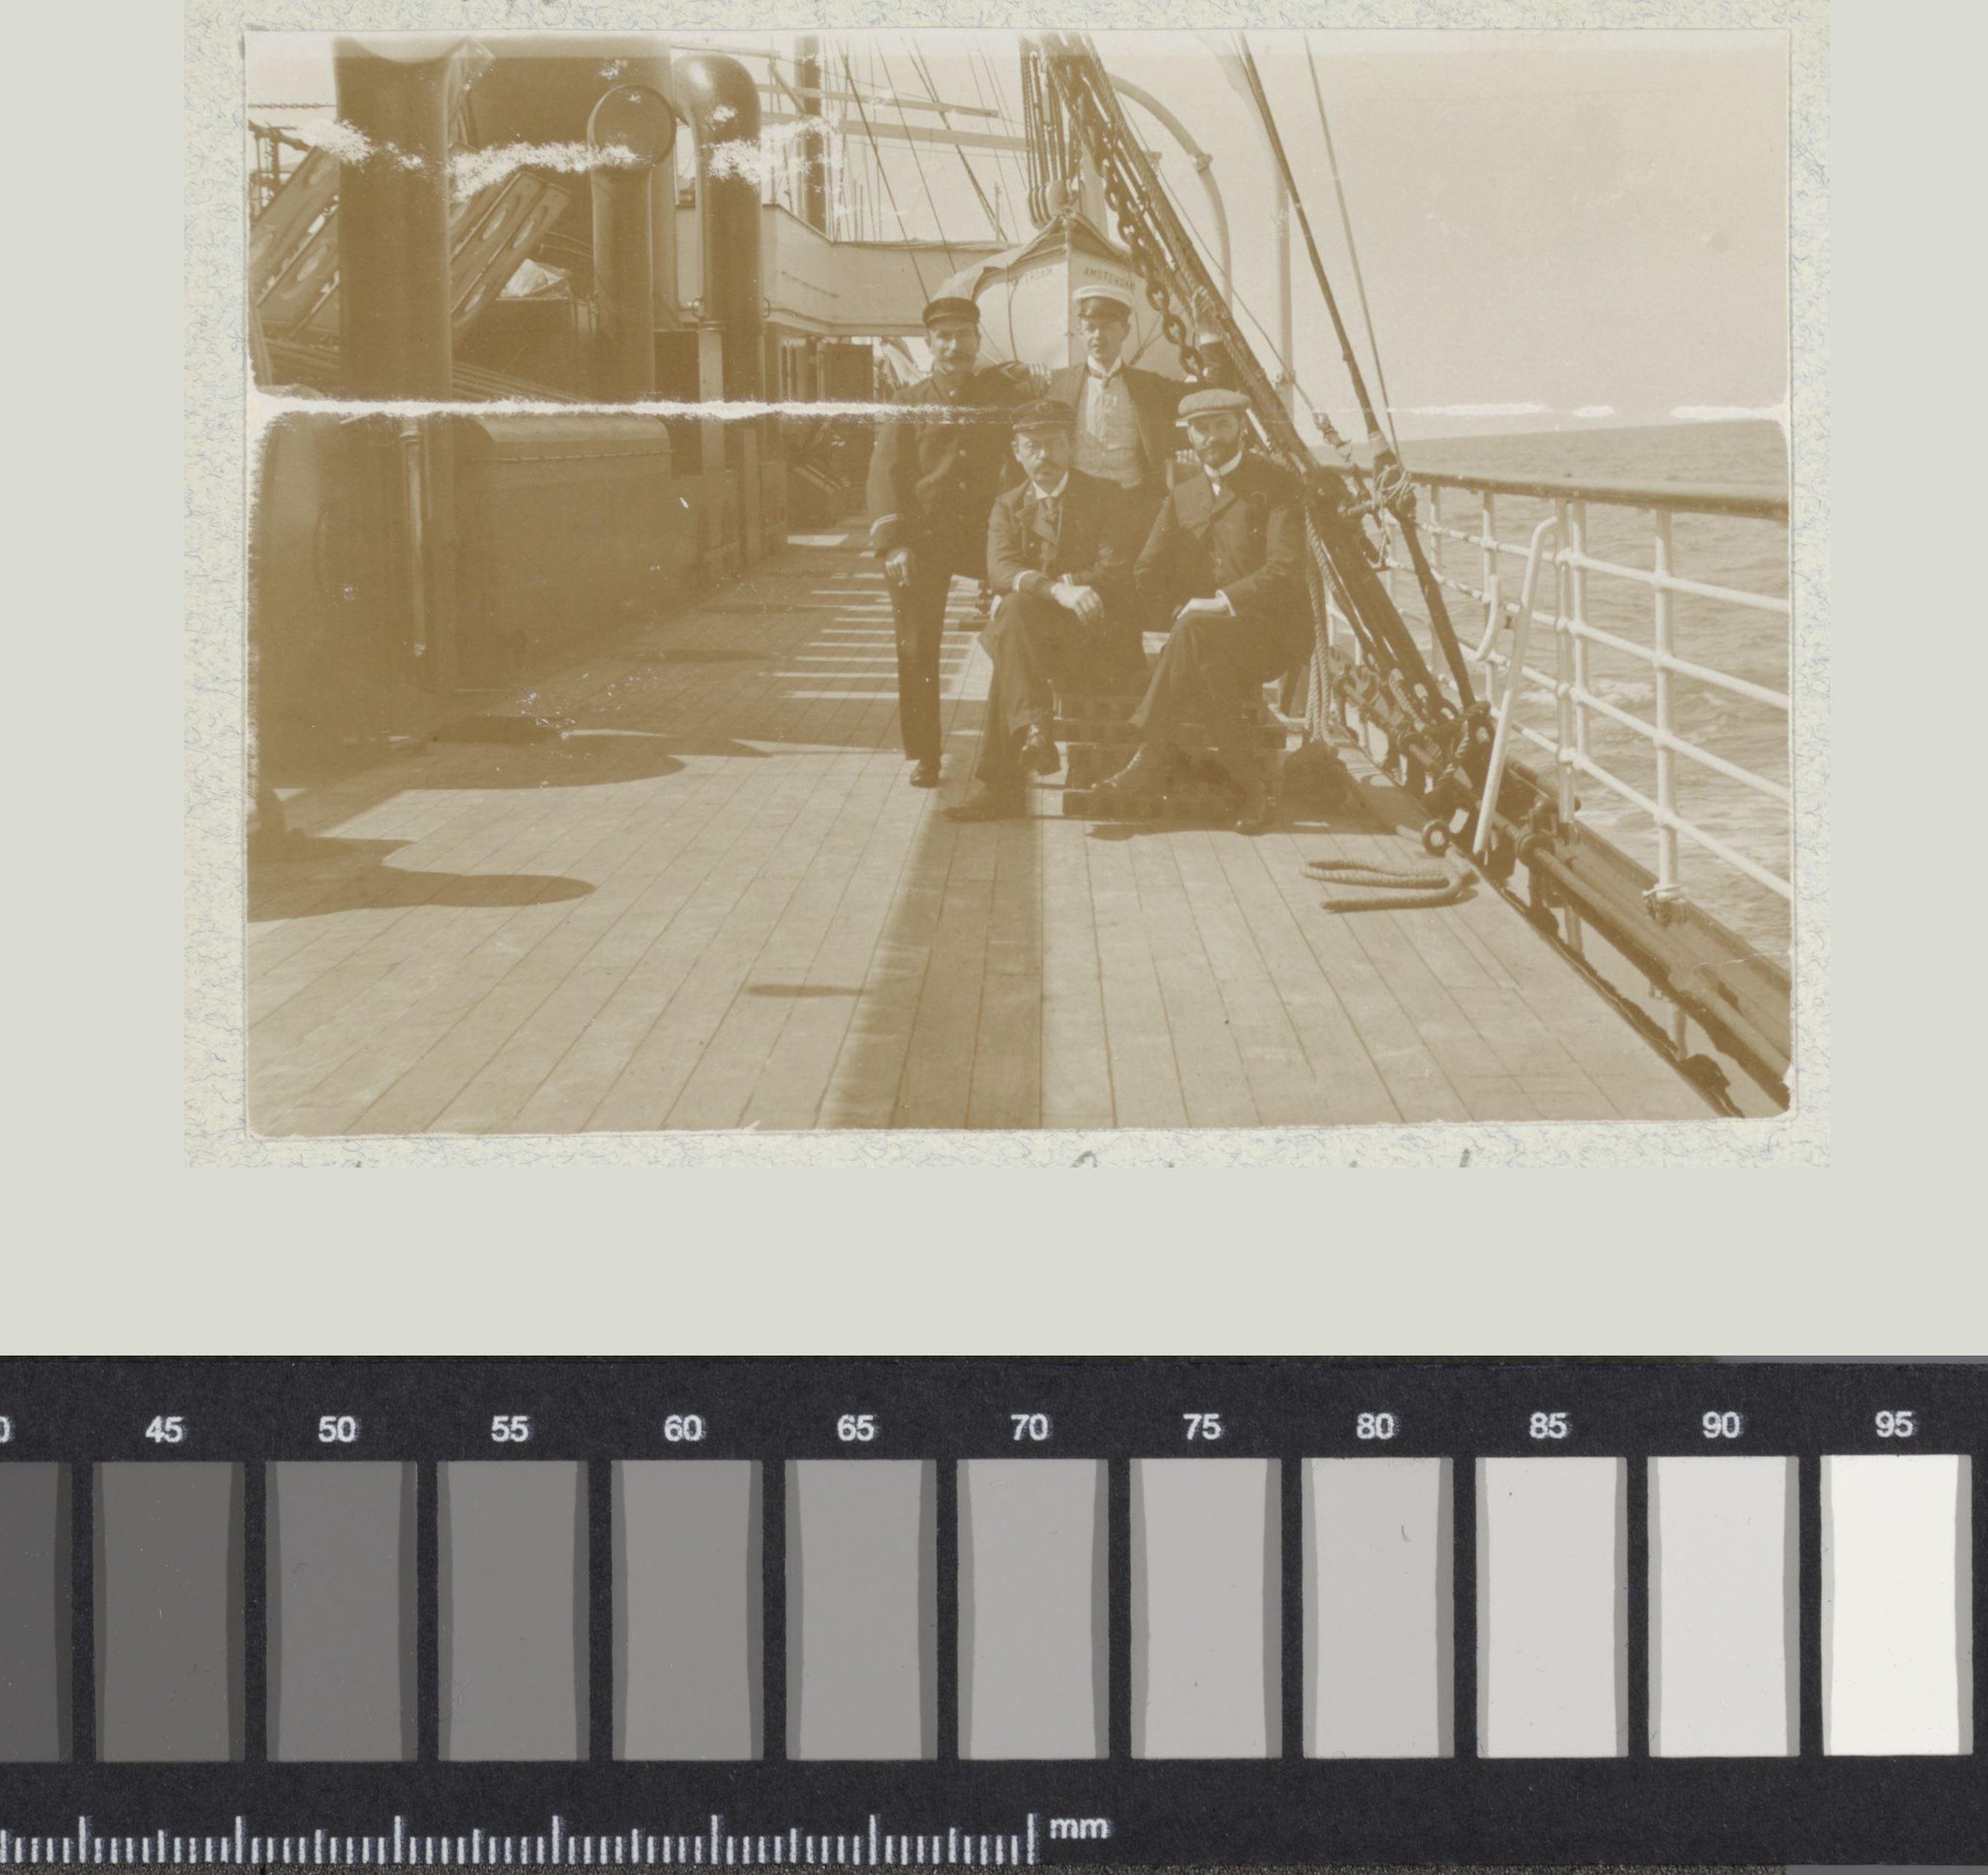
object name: photograph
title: Onderweg naar Suriname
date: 1908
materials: photographic support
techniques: photography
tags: amsterdam, andries augustus boom, passengers ~ ship, suriname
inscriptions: inscription: ‘Mer Atlantic 18/3 08. / a/b ss. Prins Frederik Hendrik’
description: Aan boord van het SS Prins Frederik Hendrik op de Atlantische Oceaan onderweg naar Suriname, 18 maart 1908. Vier mannen poseren aan dek. Onderdeel van het fotoalbum van de familie Boom-Gonggrijp in Suriname en Curaçao.